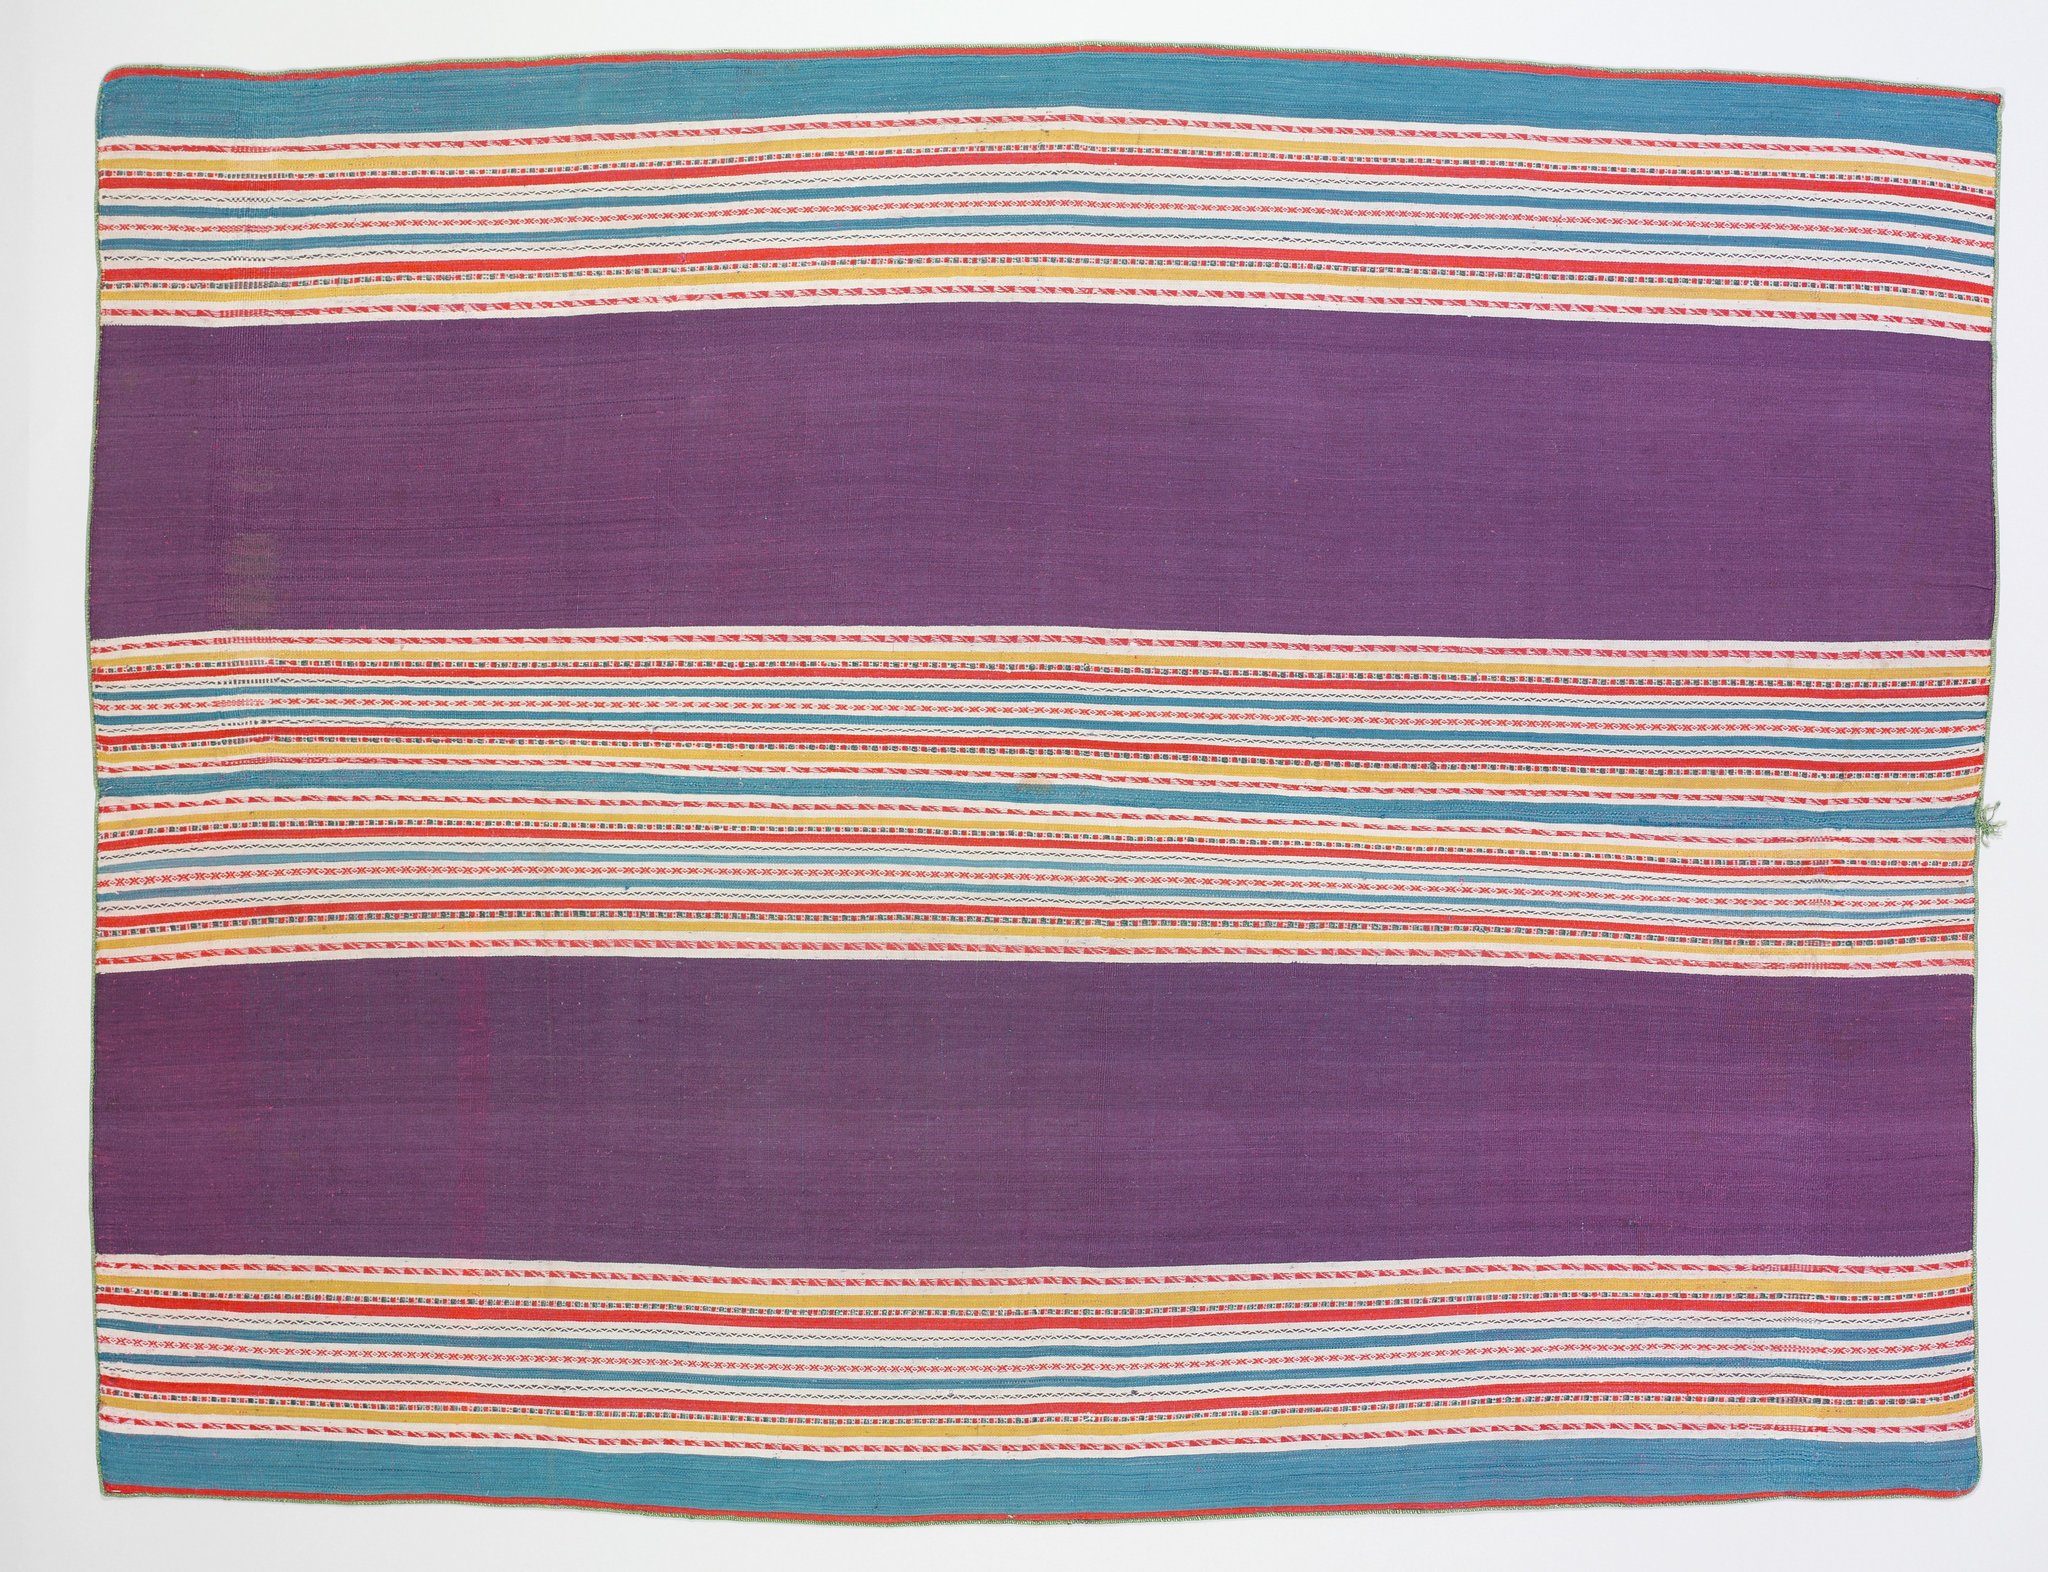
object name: mantle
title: Woman's Mantle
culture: aymara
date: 1767-1800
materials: animal fiber, silk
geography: bolivia